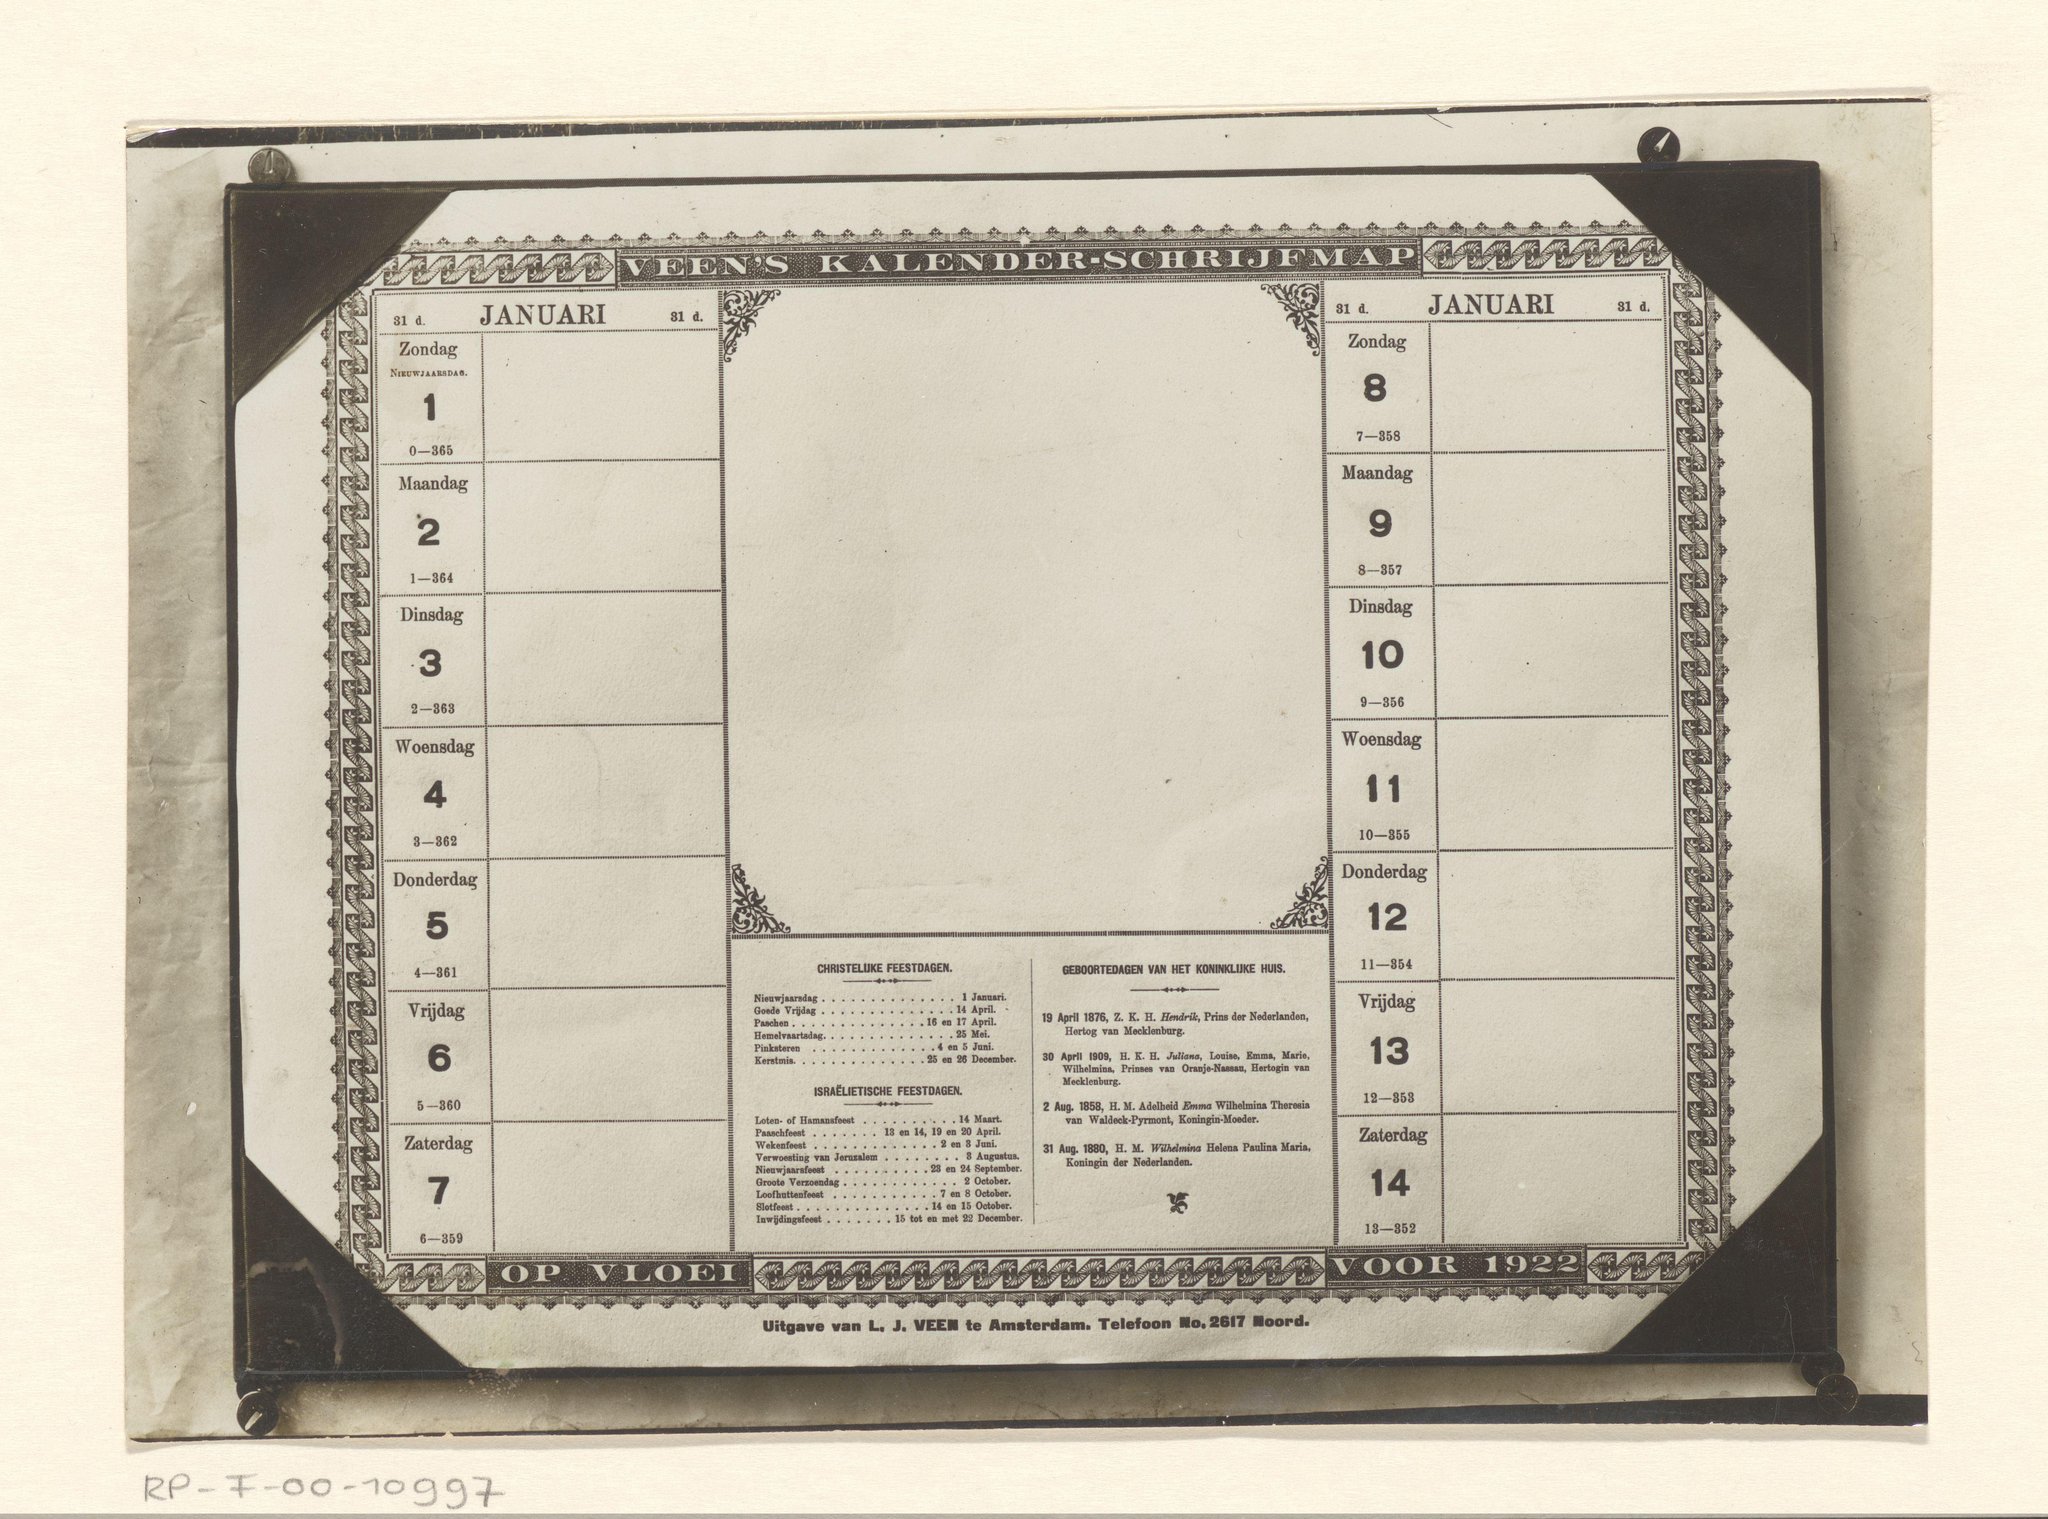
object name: photograph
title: Kalenderblad voor januari 1922 uit Veen's Kalender-Schrijfmap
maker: Anonymous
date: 1922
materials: photographic support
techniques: gelatin silver print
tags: calendar, almanac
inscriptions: number: ‘1187’, collector's mark: Lugt 2228a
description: Kalenderblad van 1 tot en met 14 januari 1922 uit Veen's Kalender-Schrijfmap op vloeikarton met notitieruimte en vermelding van feestdagen en geboortedagen van het Koninklijk Huis.